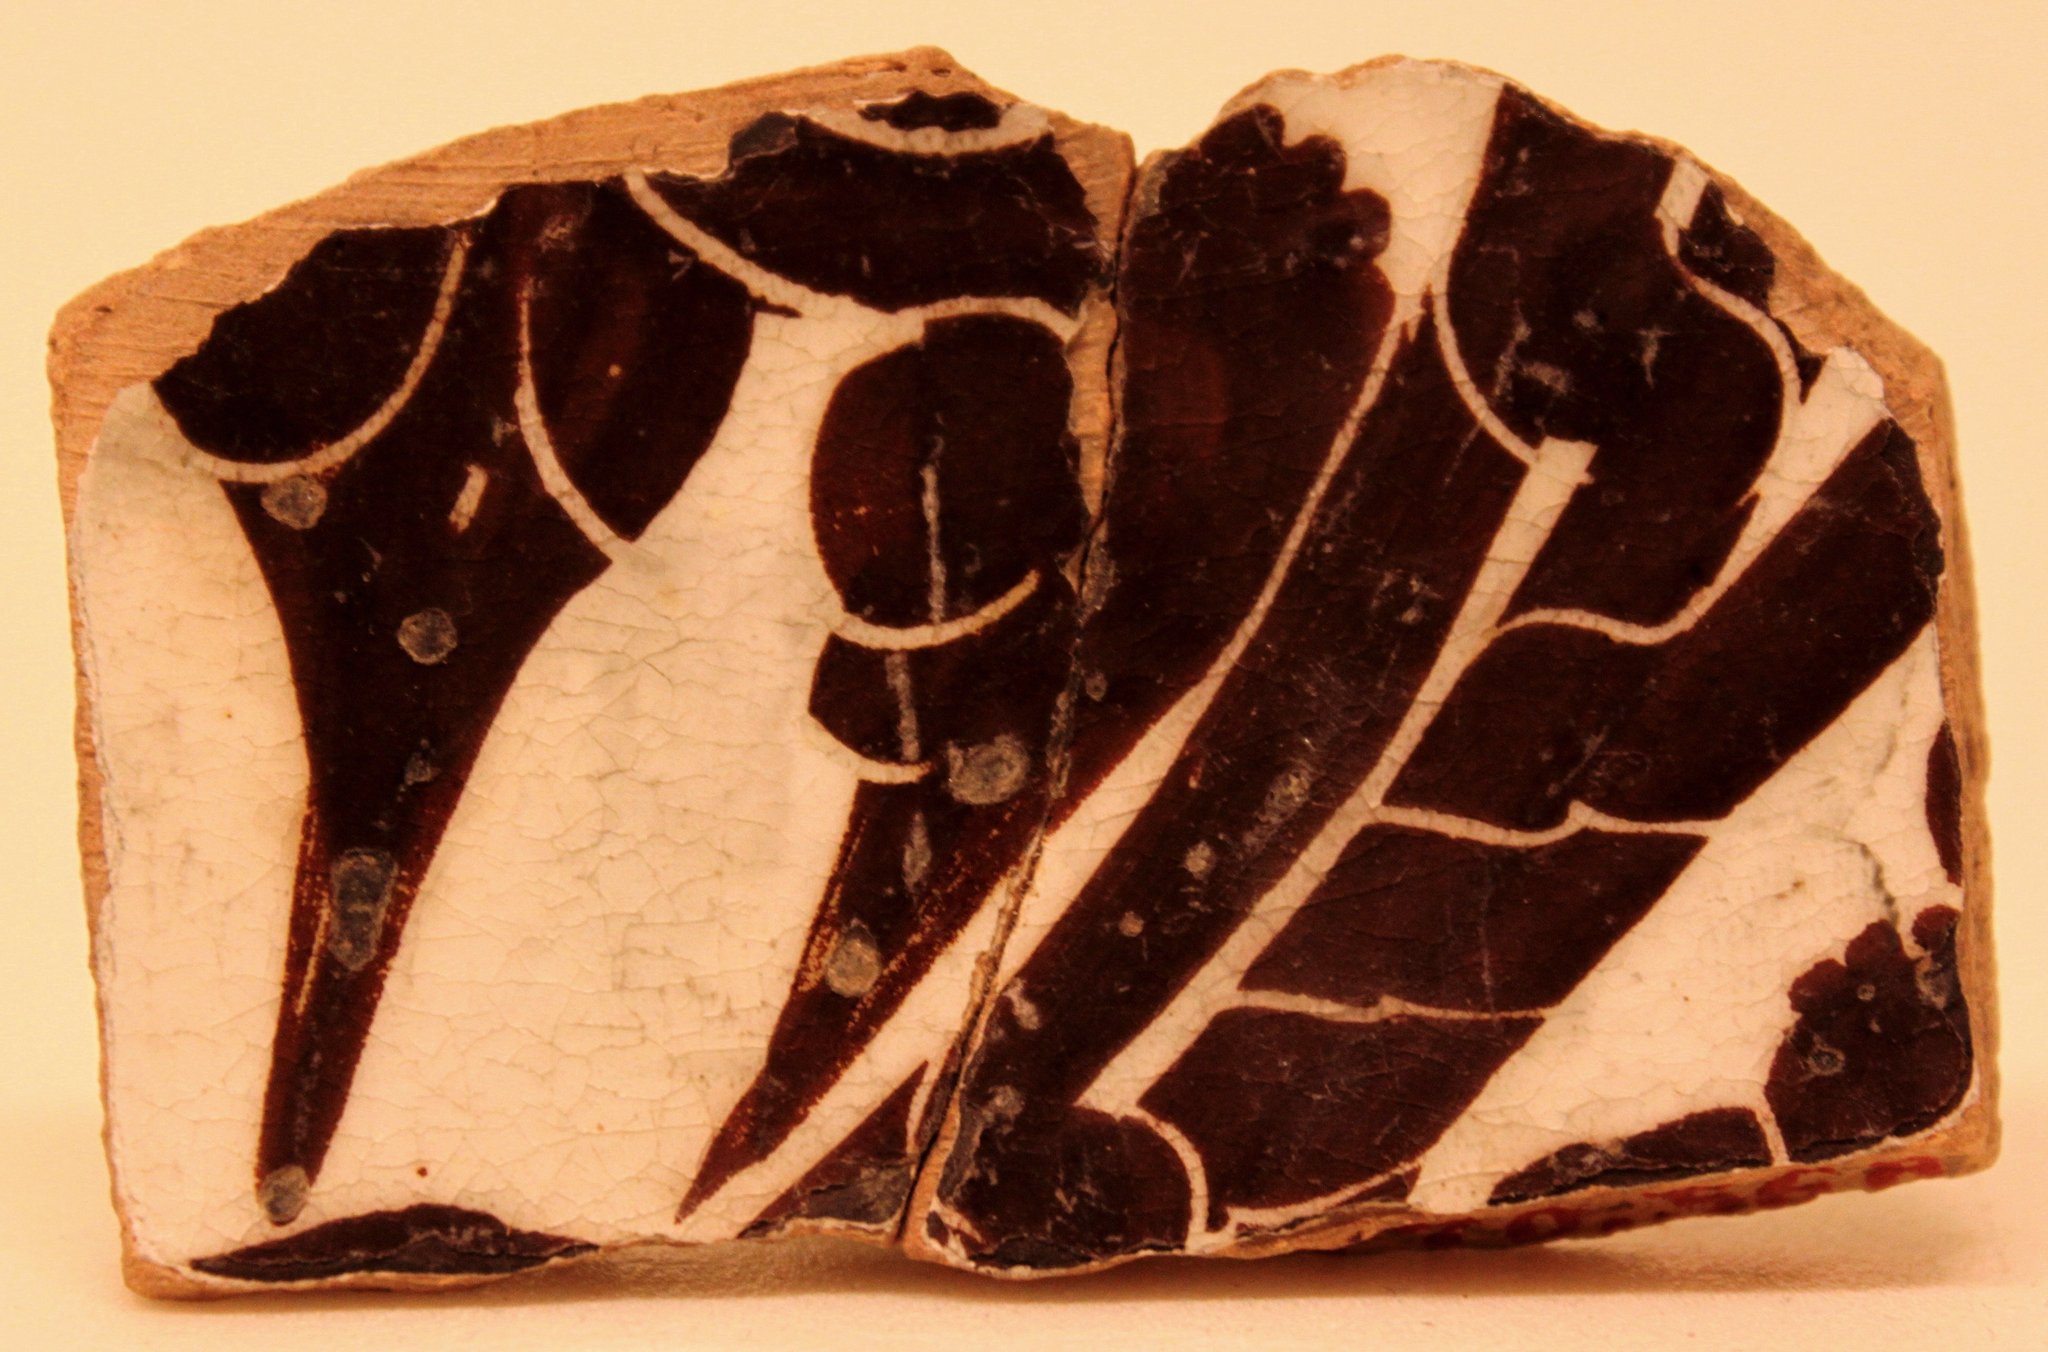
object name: fragment of a bowl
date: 801-1000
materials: earthenware, glaze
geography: iran